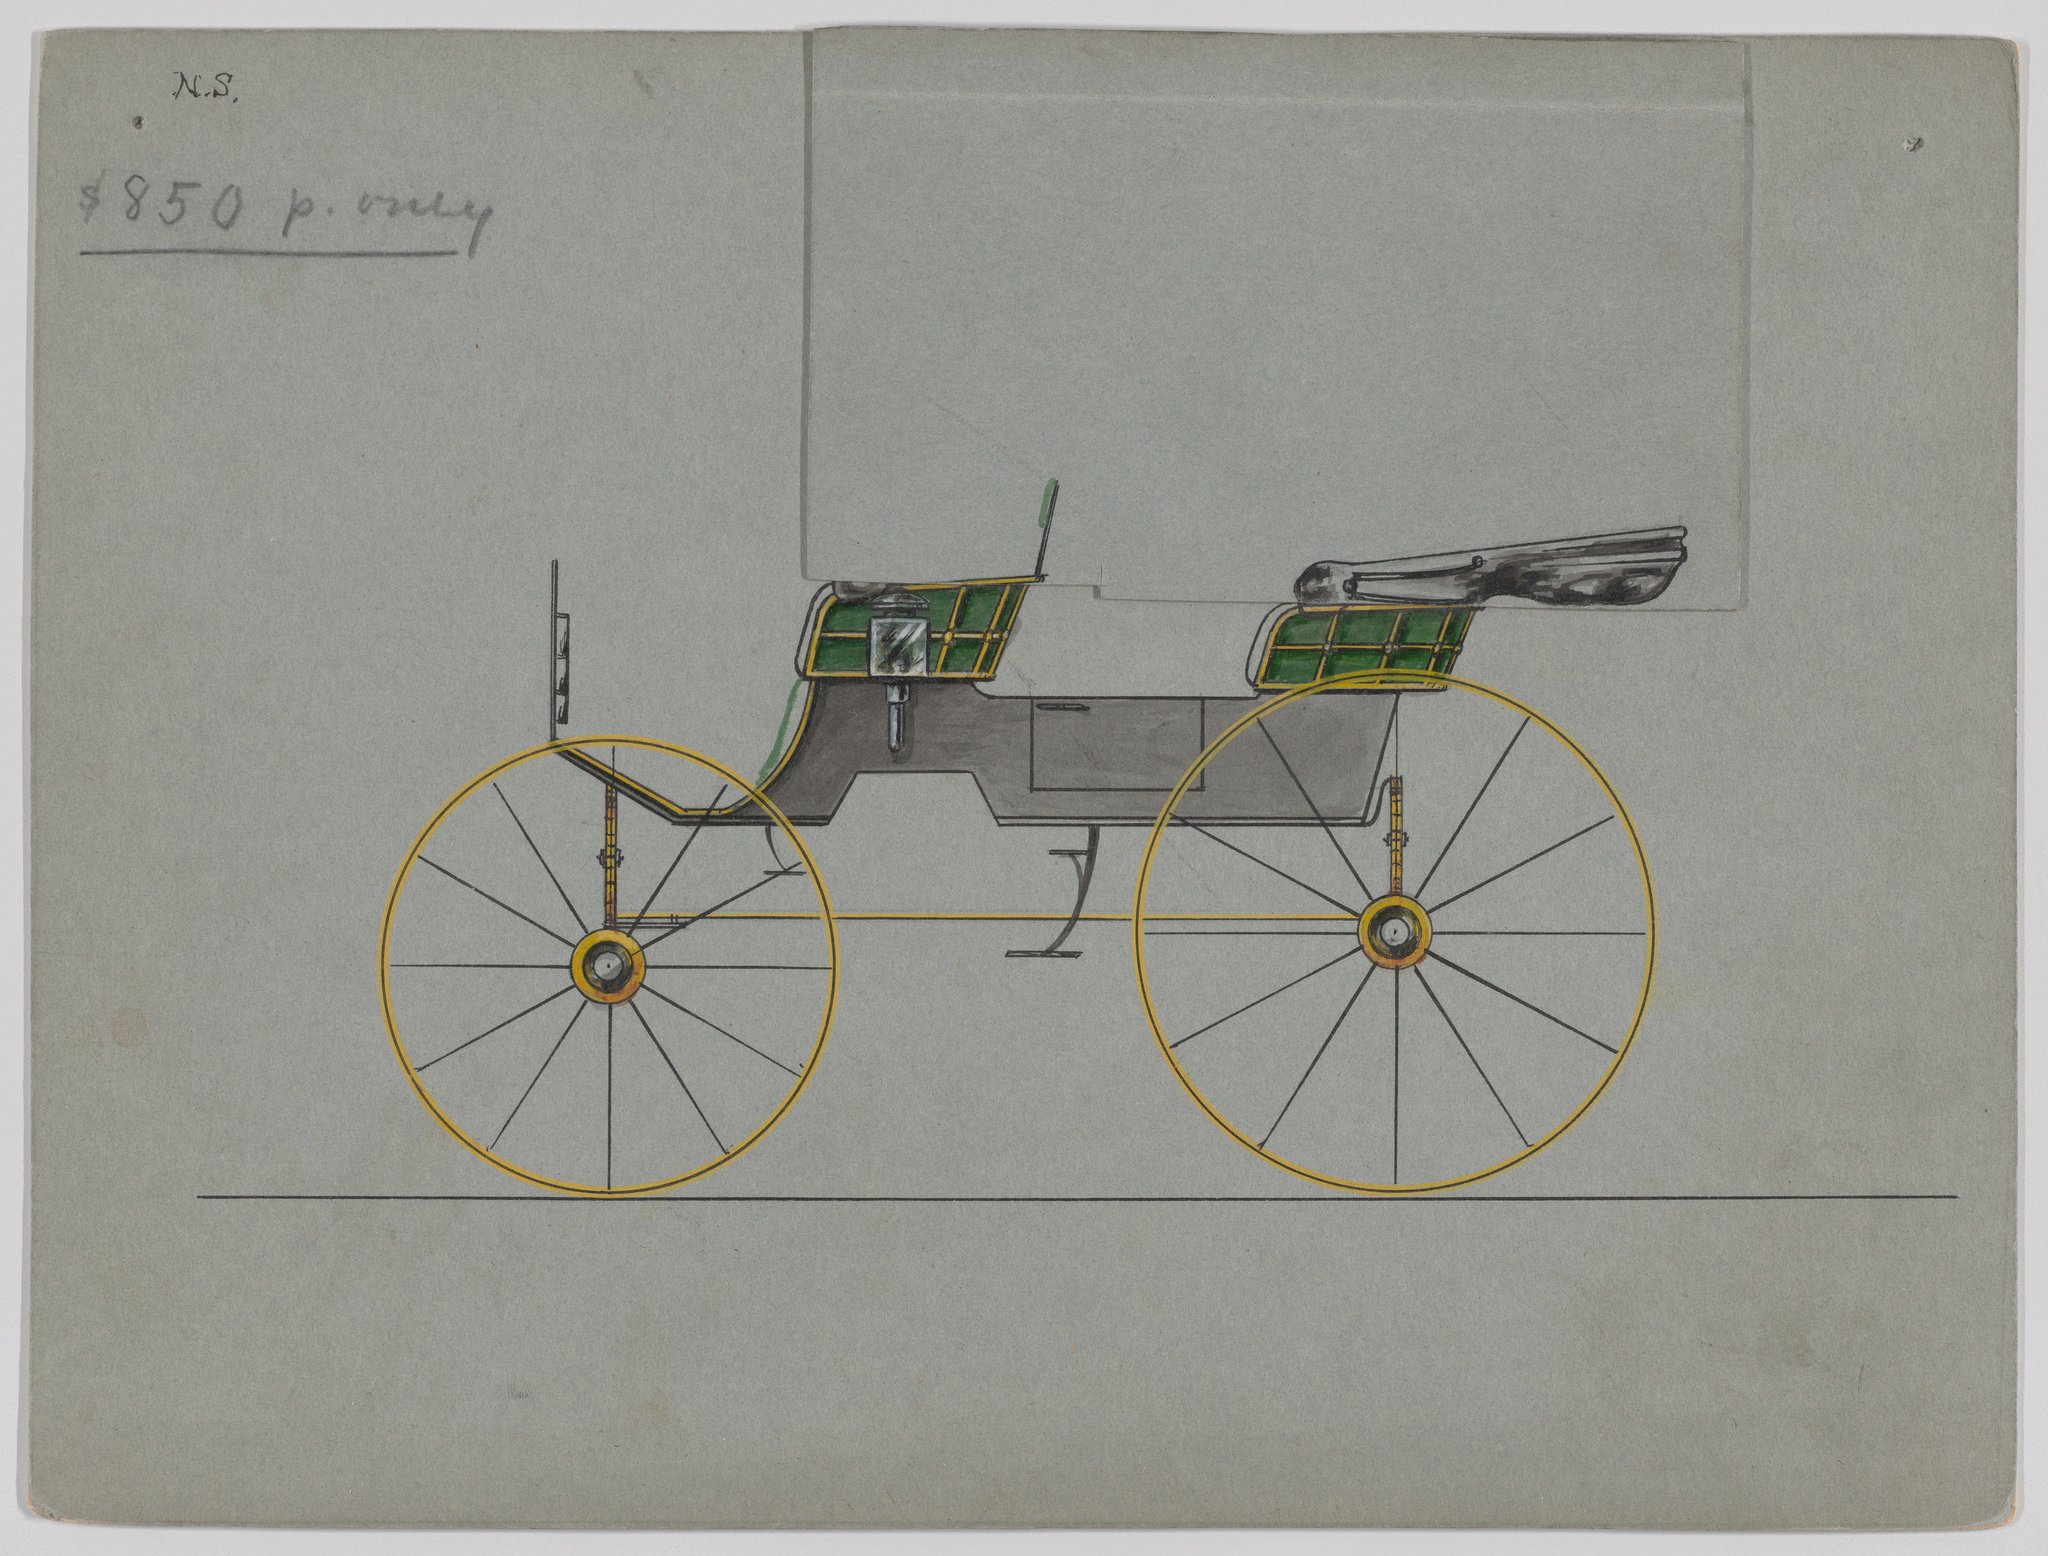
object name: drawing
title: Two-seat Phaeton #3938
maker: brewster & co.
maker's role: manufacturer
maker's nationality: american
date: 1885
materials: gouache, gum arabic, watercolor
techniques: pen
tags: carriages